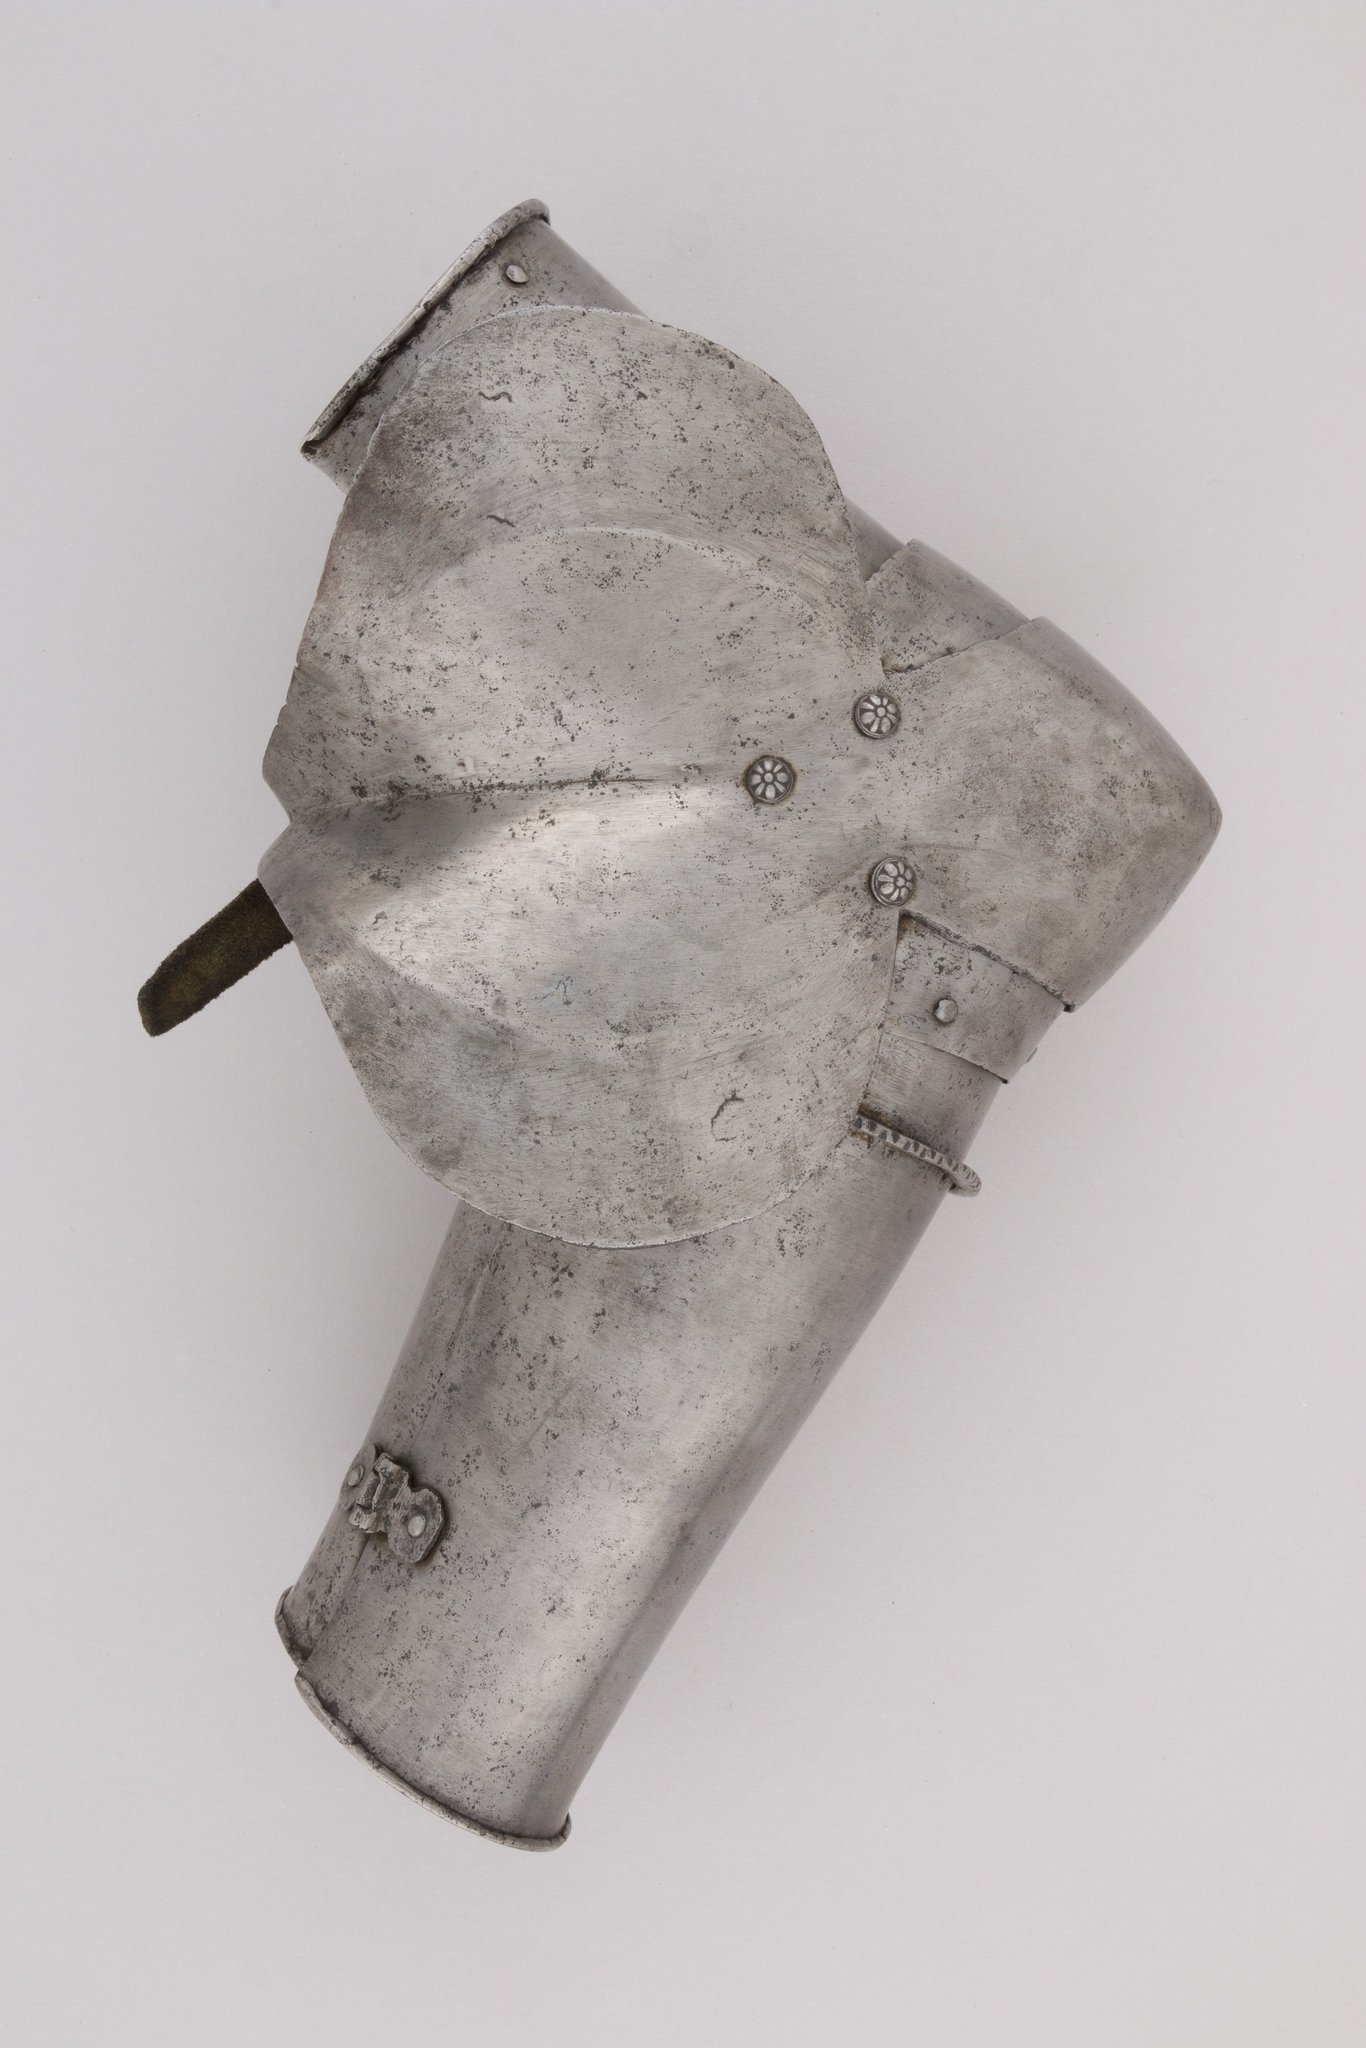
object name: inner plate of a forearm defense vambrace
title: Outer Plate of a Forearm Defense (Vambrace)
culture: italian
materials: leather, steel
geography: italy